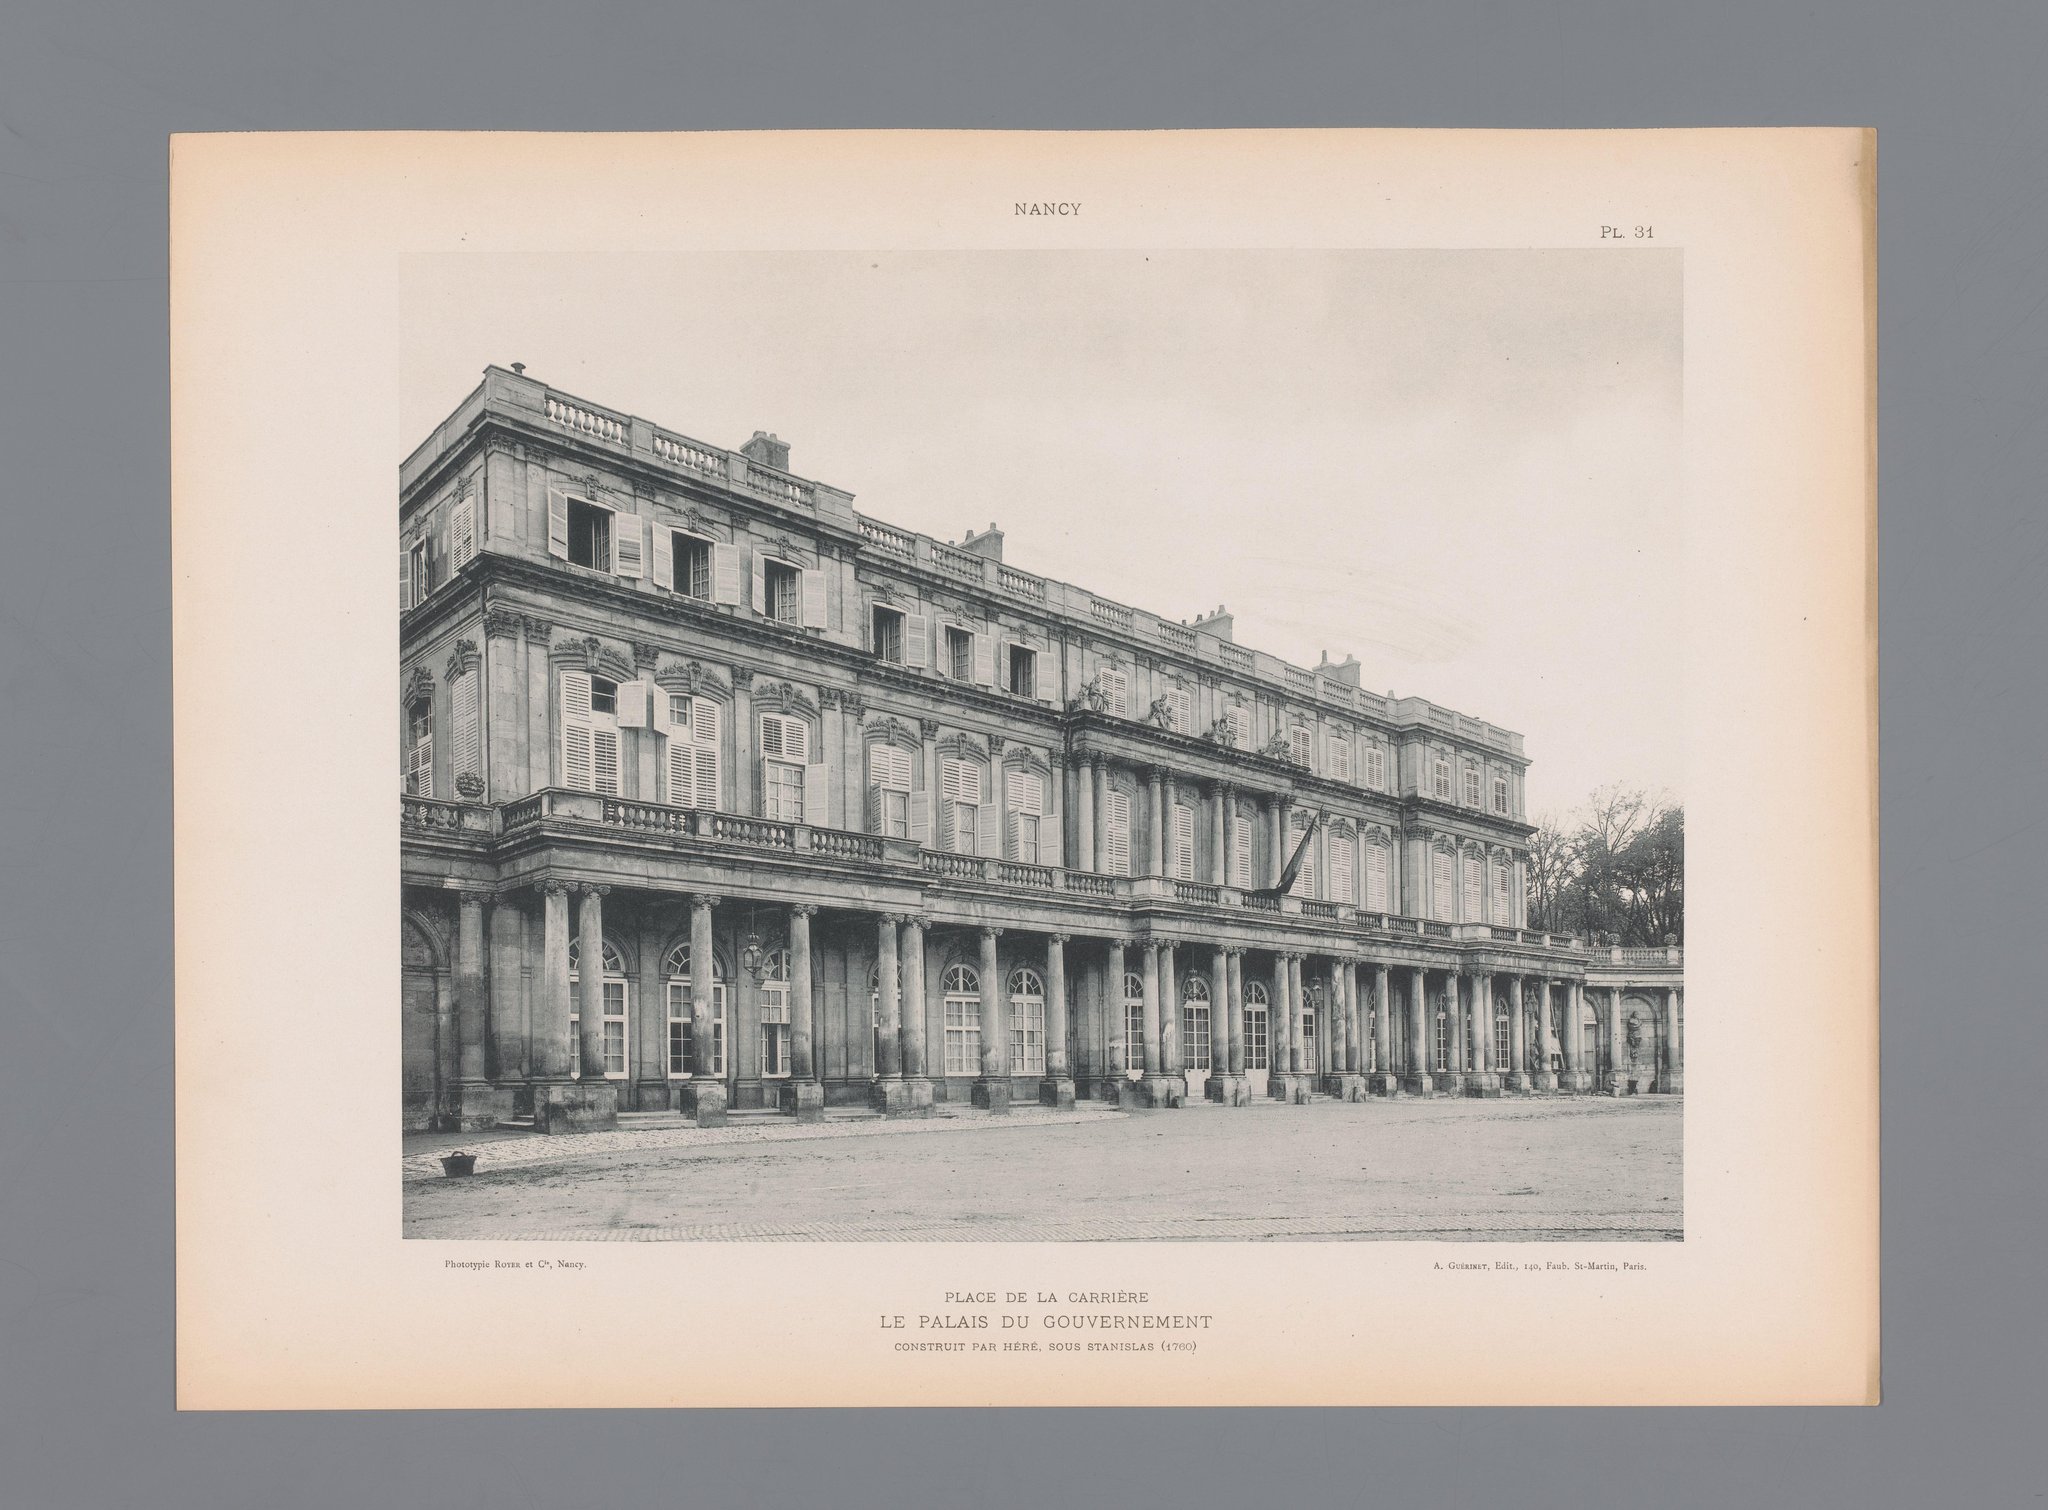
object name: photomechanical print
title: Façade van het Palais du gouvernement de Nancy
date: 1891-1896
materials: paper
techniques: photograph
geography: paris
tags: palace, façade (of house or building)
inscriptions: inscription: ‘Place de la carrière/ le palais du gouvernement (...)’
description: Deze prent maakt deel uit van een omslag met 103 prenten op 101 bladen en een titelblad.